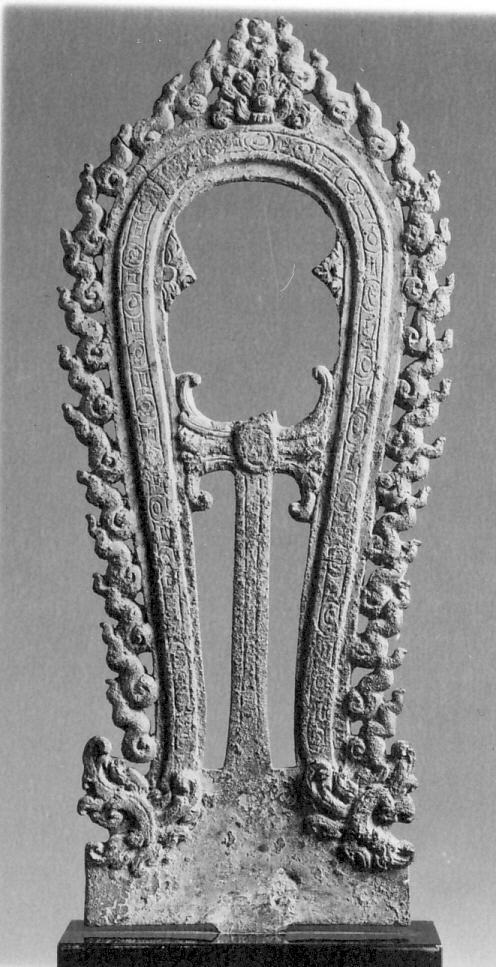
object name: halo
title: Holy Prabha (Halo for a Buddhist Deity)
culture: indonesian, javanese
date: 801-900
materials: bronze